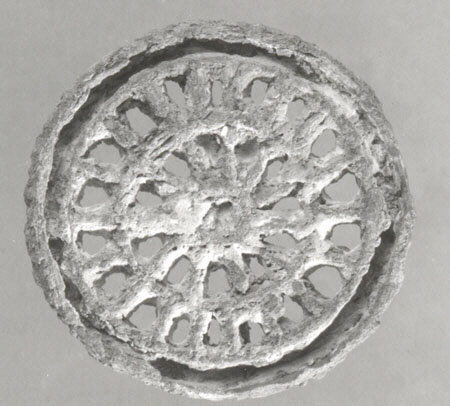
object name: stamp seal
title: Compartmented stamp seal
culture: bactria-margiana archaeological complex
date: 2333-1668 BCE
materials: copper alloy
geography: bactria-margiana